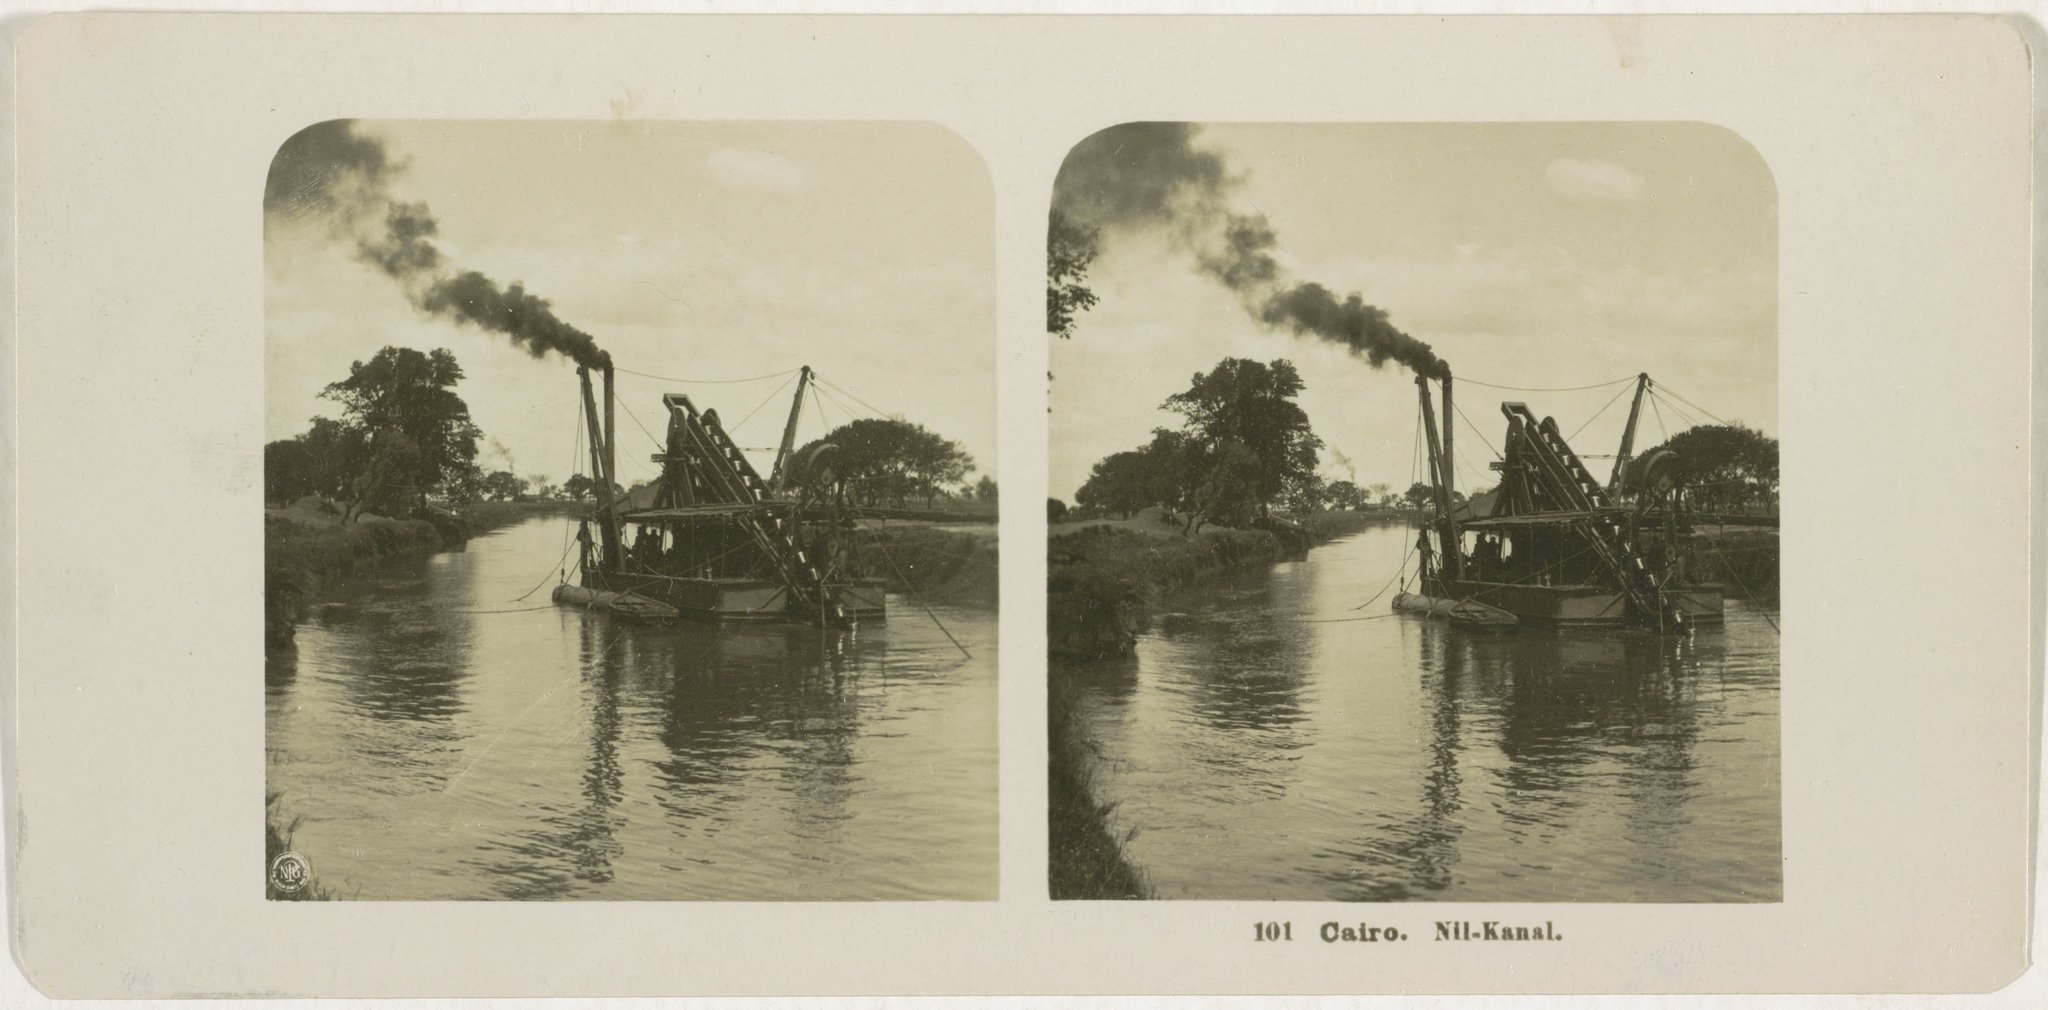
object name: stereograph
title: Emmerbaggermolen in de Nijl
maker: Anonymous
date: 1909-1935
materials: paper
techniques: gelatin silver print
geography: cairo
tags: ships (in general)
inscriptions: number: ‘101’